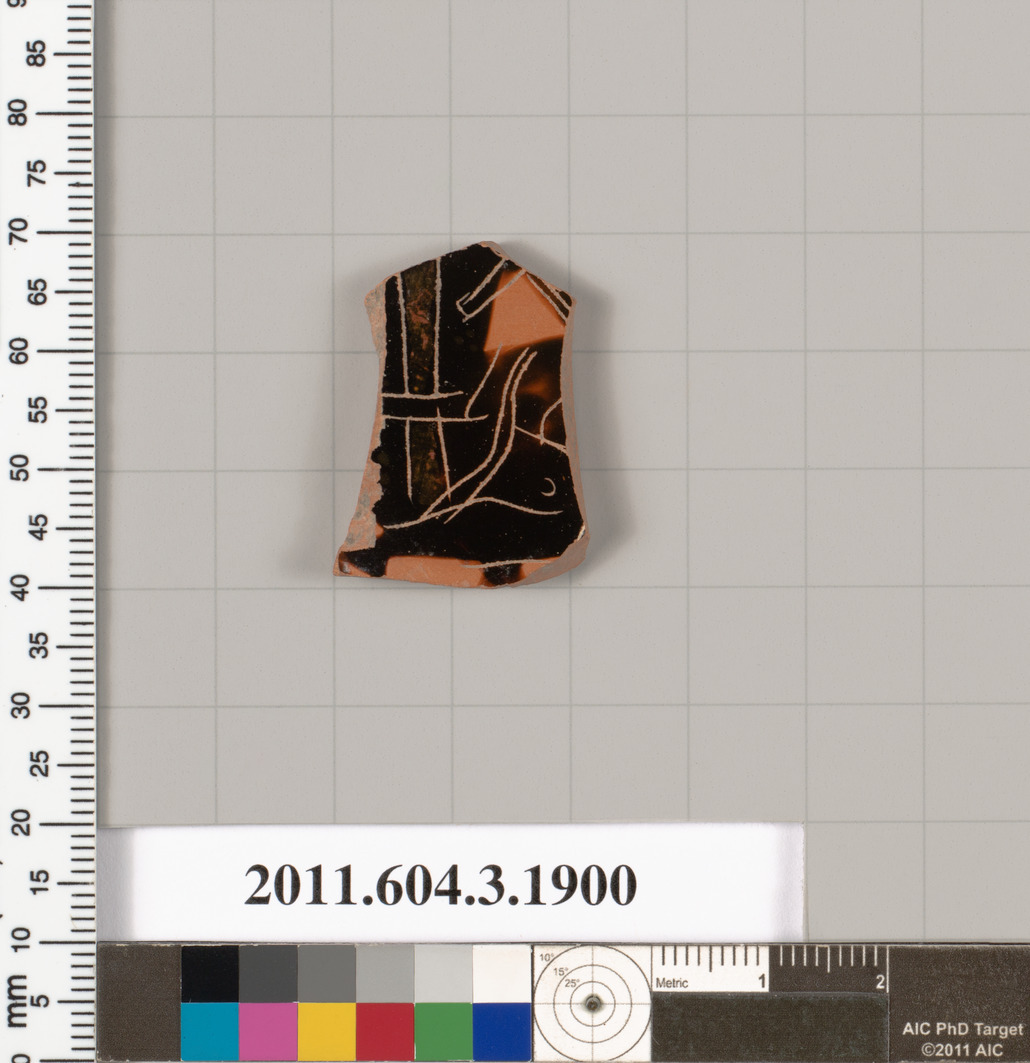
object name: kylix fragment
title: Terracotta fragment of a kylix (drinking cup)?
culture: greek, attic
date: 550-526 BCE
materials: terracotta